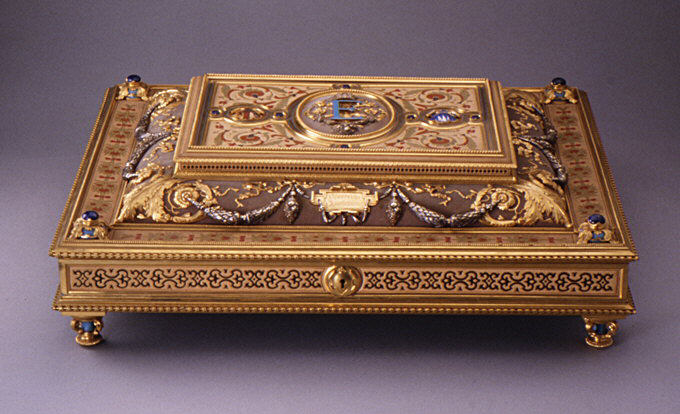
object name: casket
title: Presentation casket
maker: josef ritter von storck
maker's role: designer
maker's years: 1830-1902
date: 1867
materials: enamel, lapis lazuli, leather, silver gilt